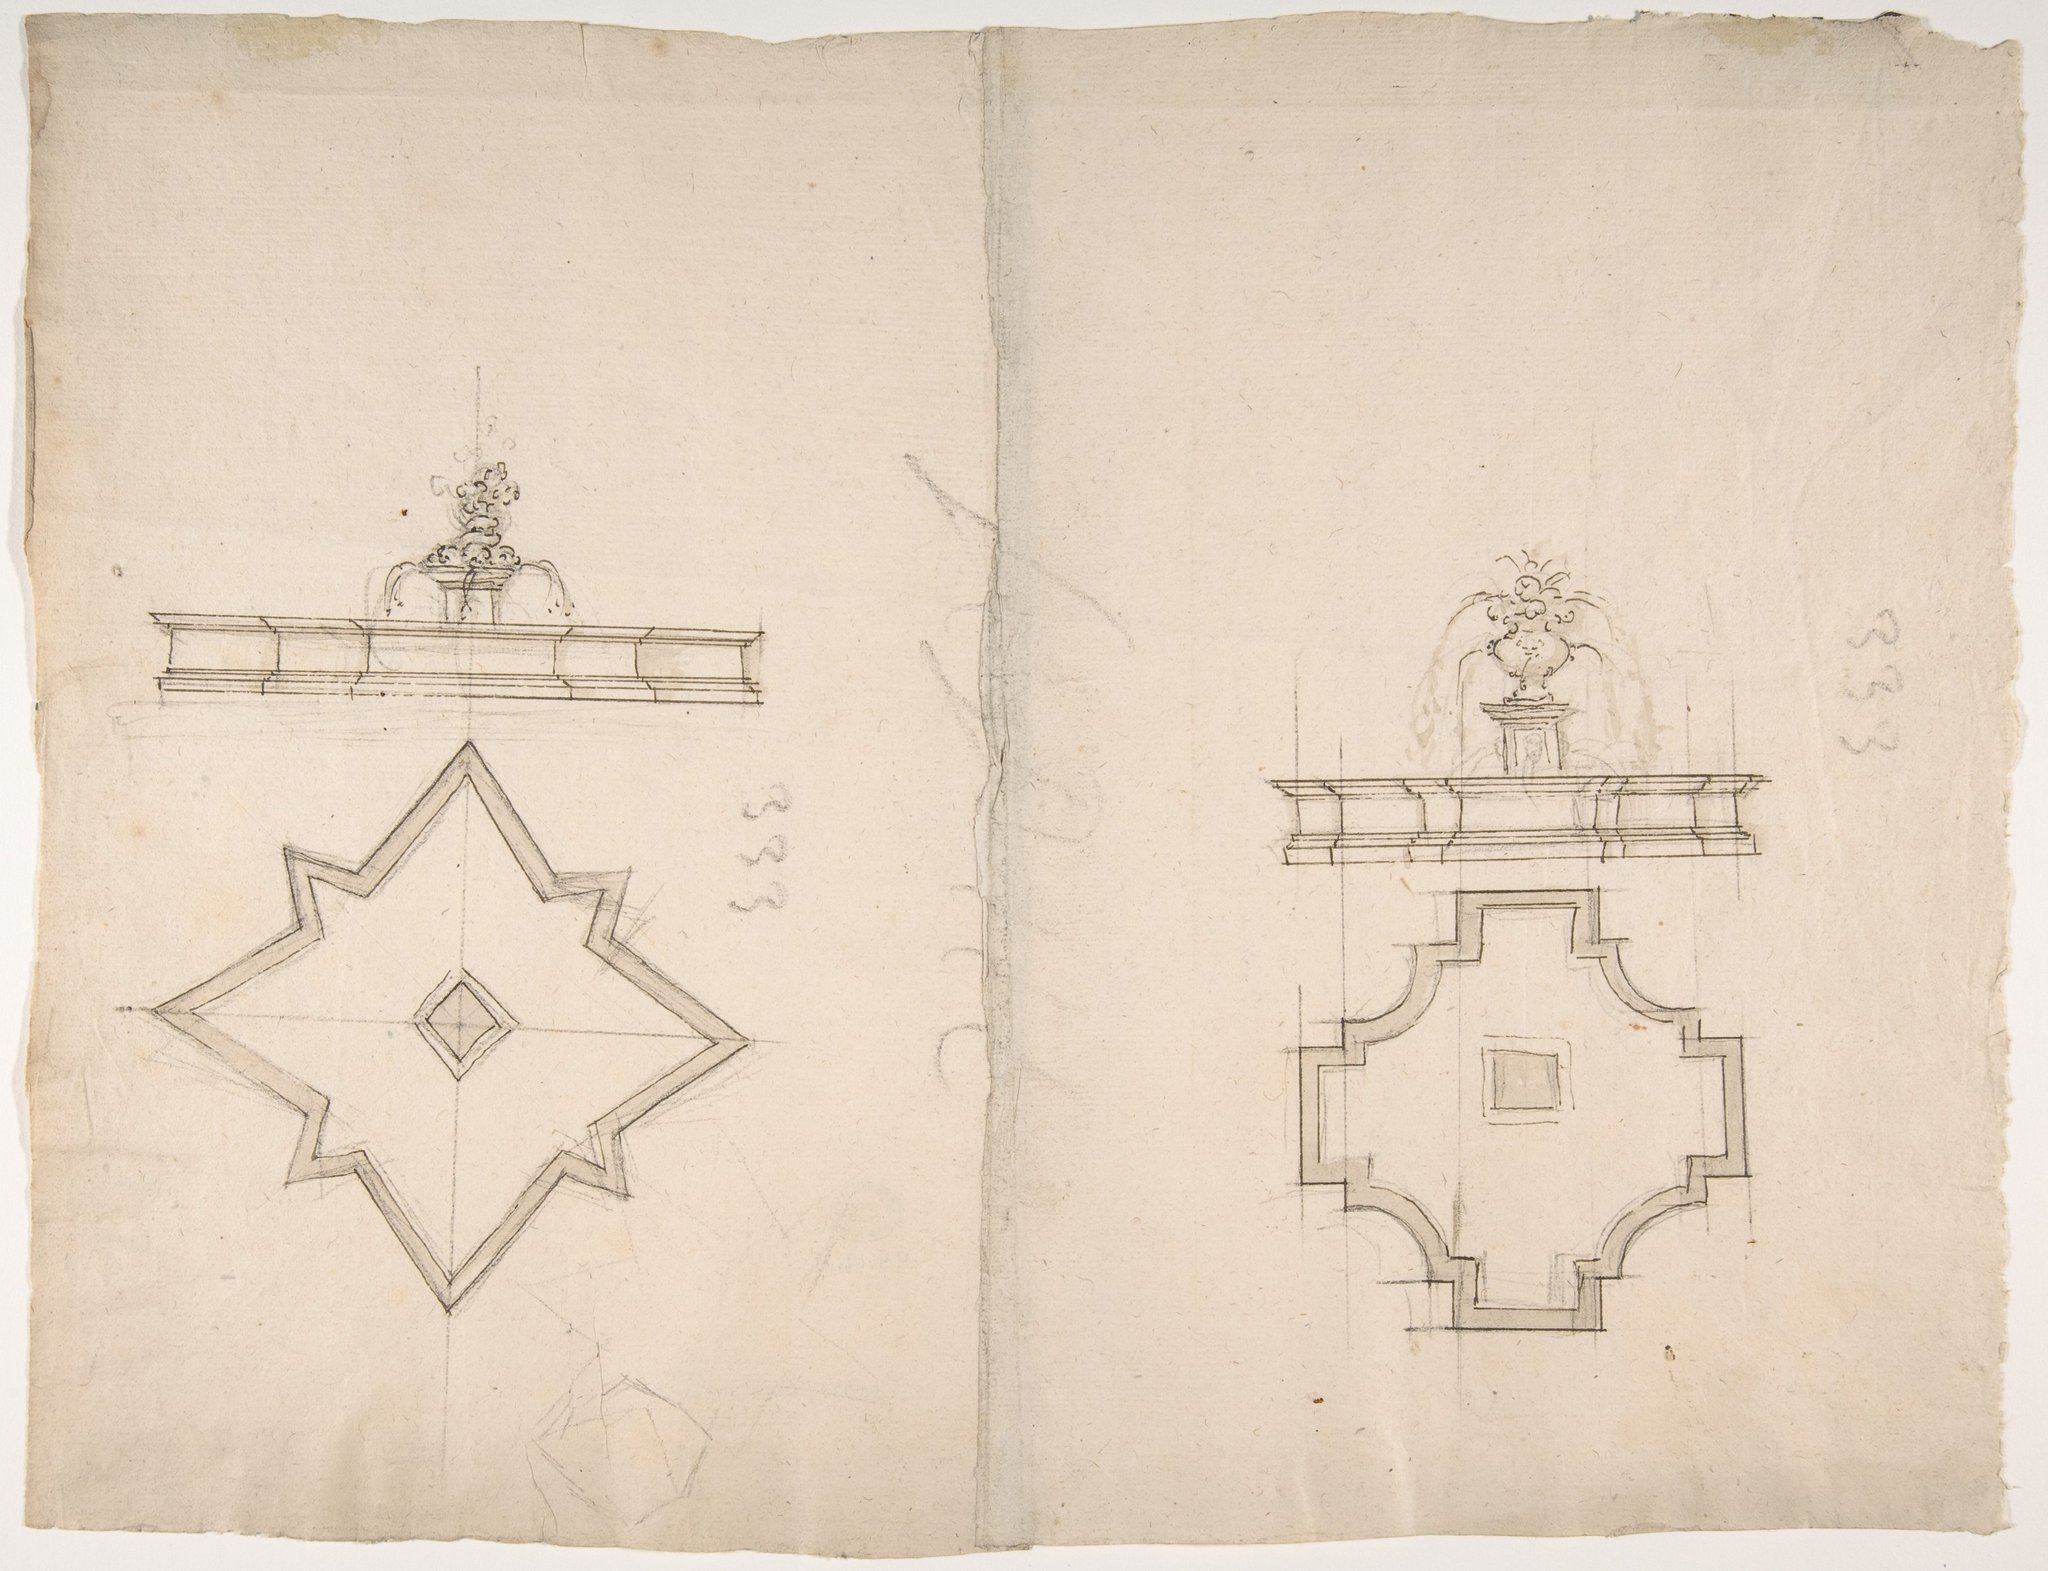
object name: drawing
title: Two Plans and Elevations for Fountains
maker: anonymous, french, 16th century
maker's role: artist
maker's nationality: french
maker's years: 1500-1600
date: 1501-1600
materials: chalk, ink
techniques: brush, pen, wash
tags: architecture,fountains